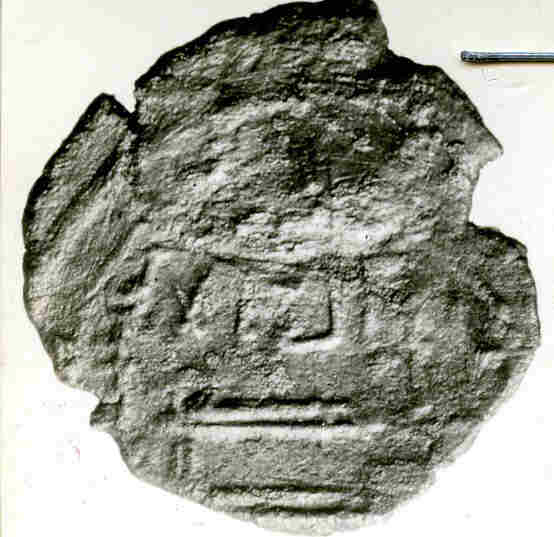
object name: coin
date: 790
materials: copper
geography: iran